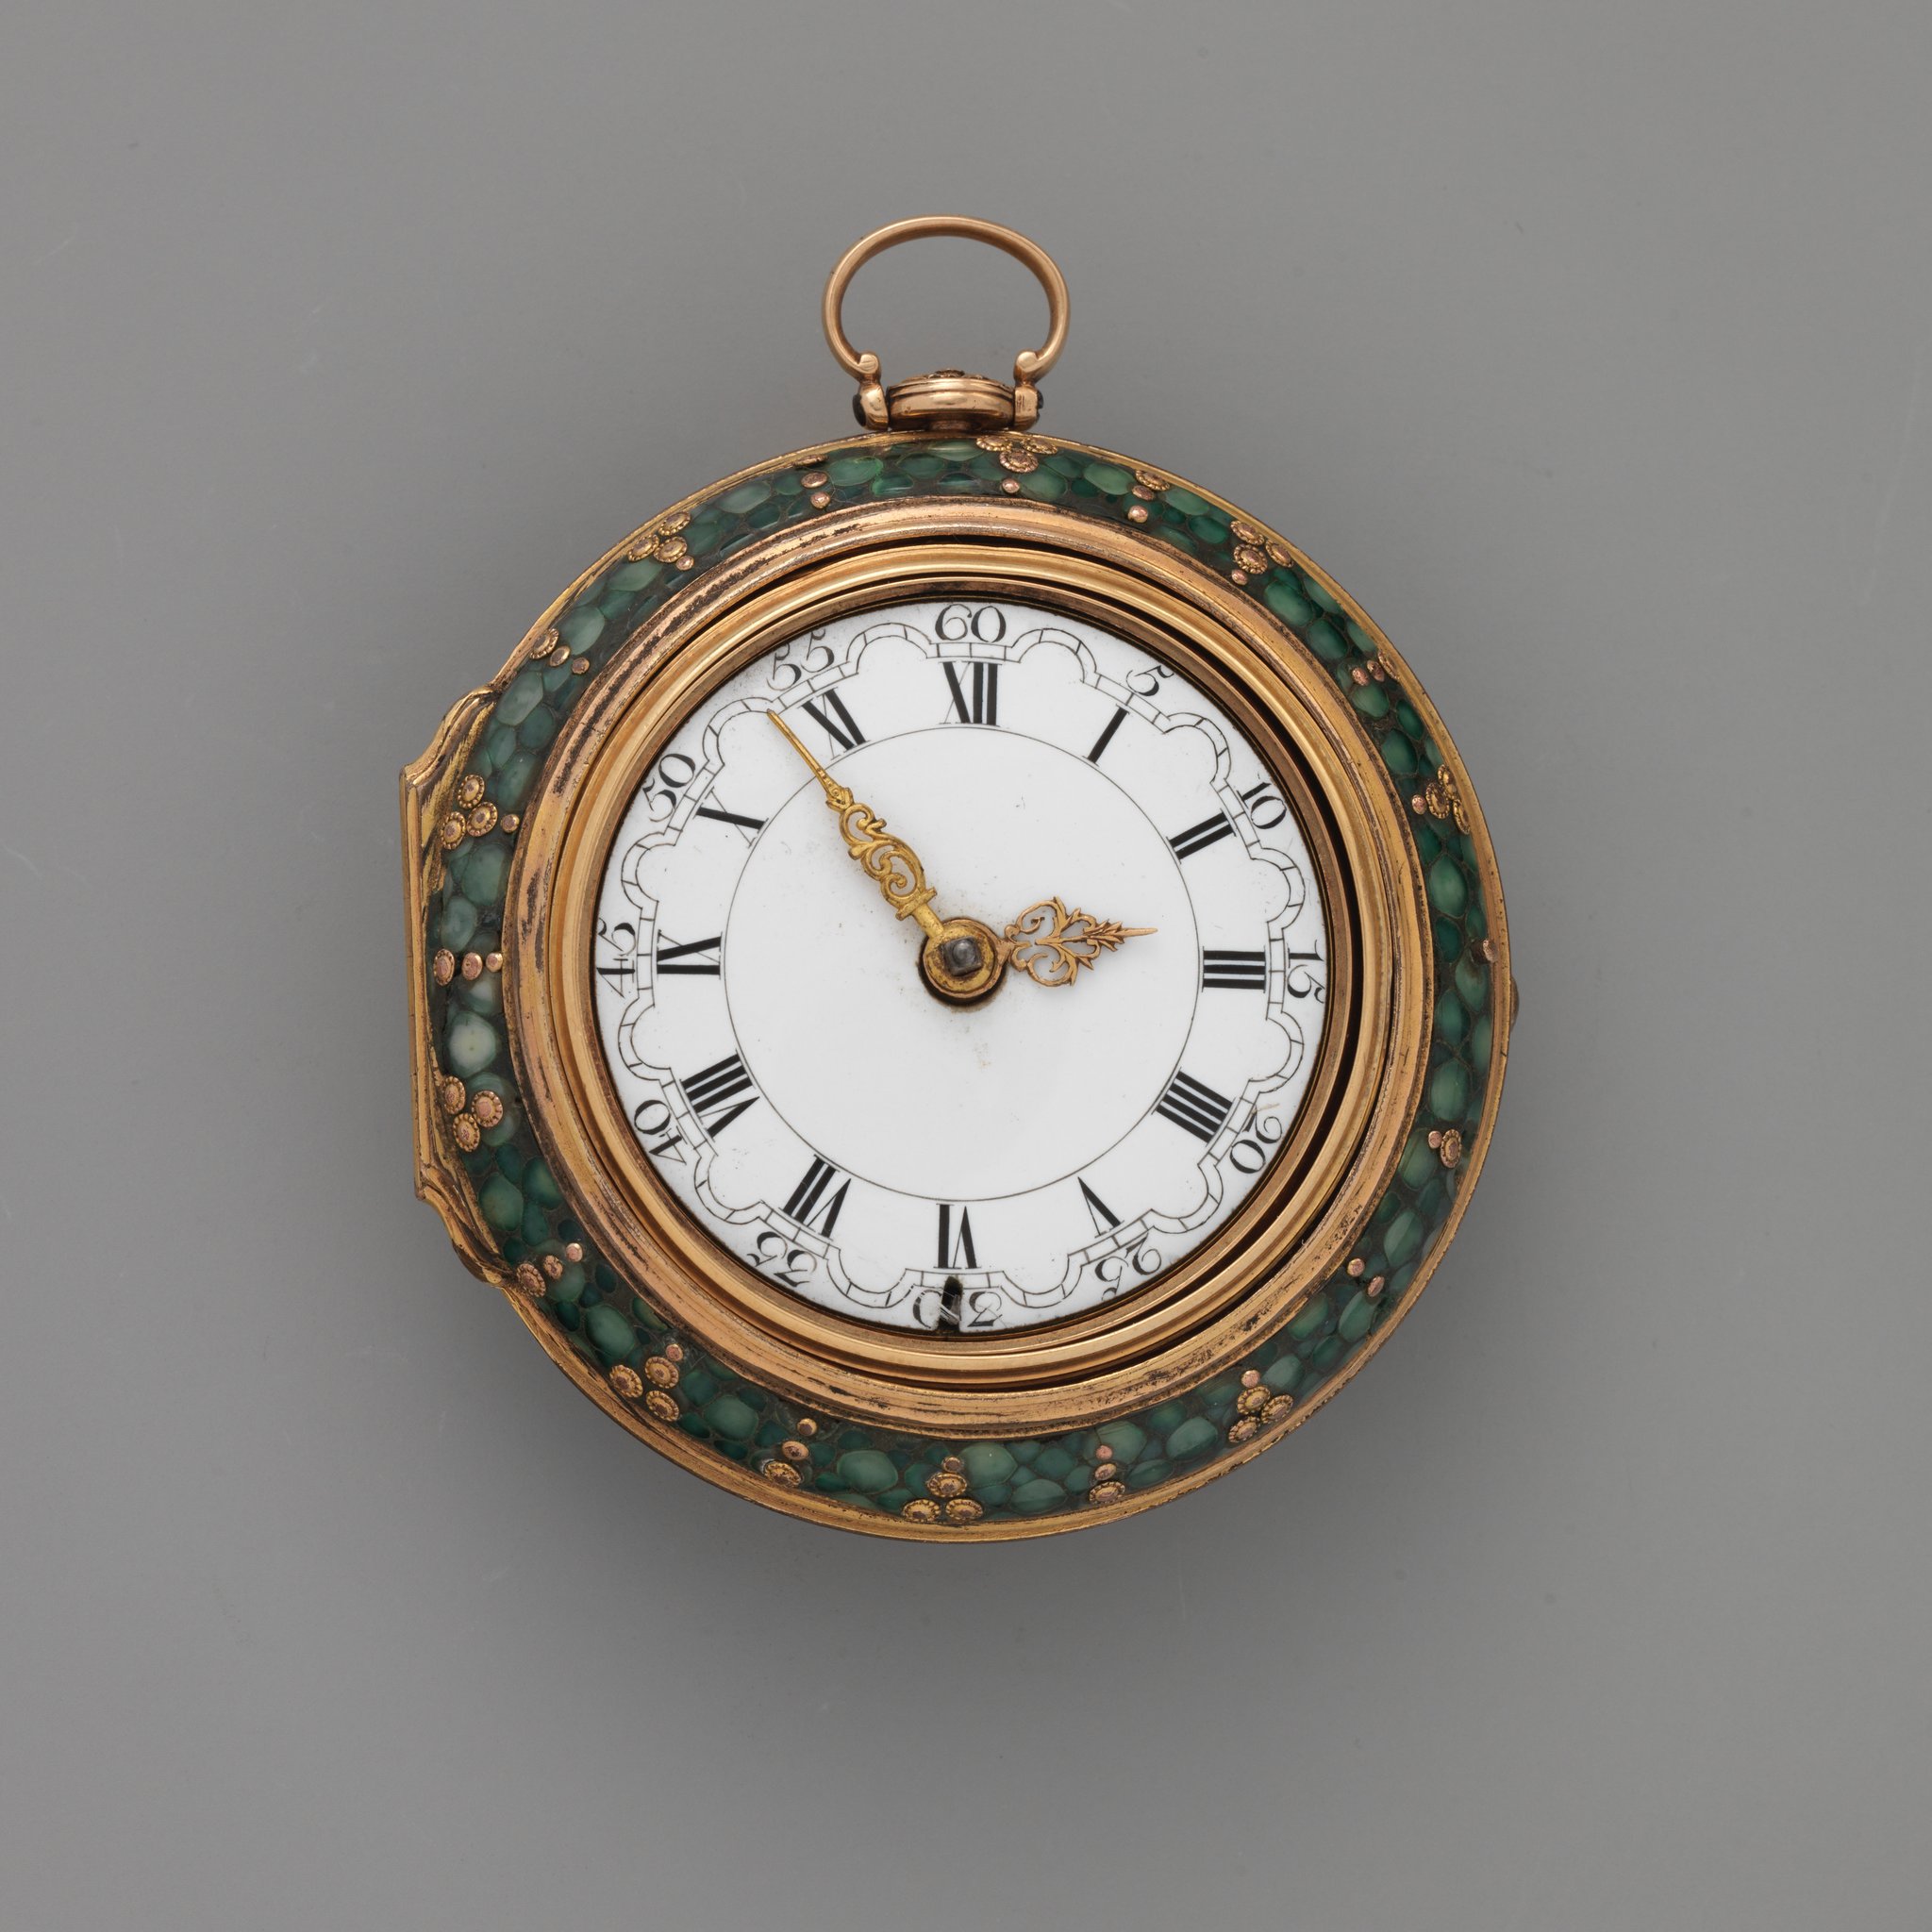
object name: watch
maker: william rivers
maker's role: maker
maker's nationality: british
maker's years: 1720-1820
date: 1770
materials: gold